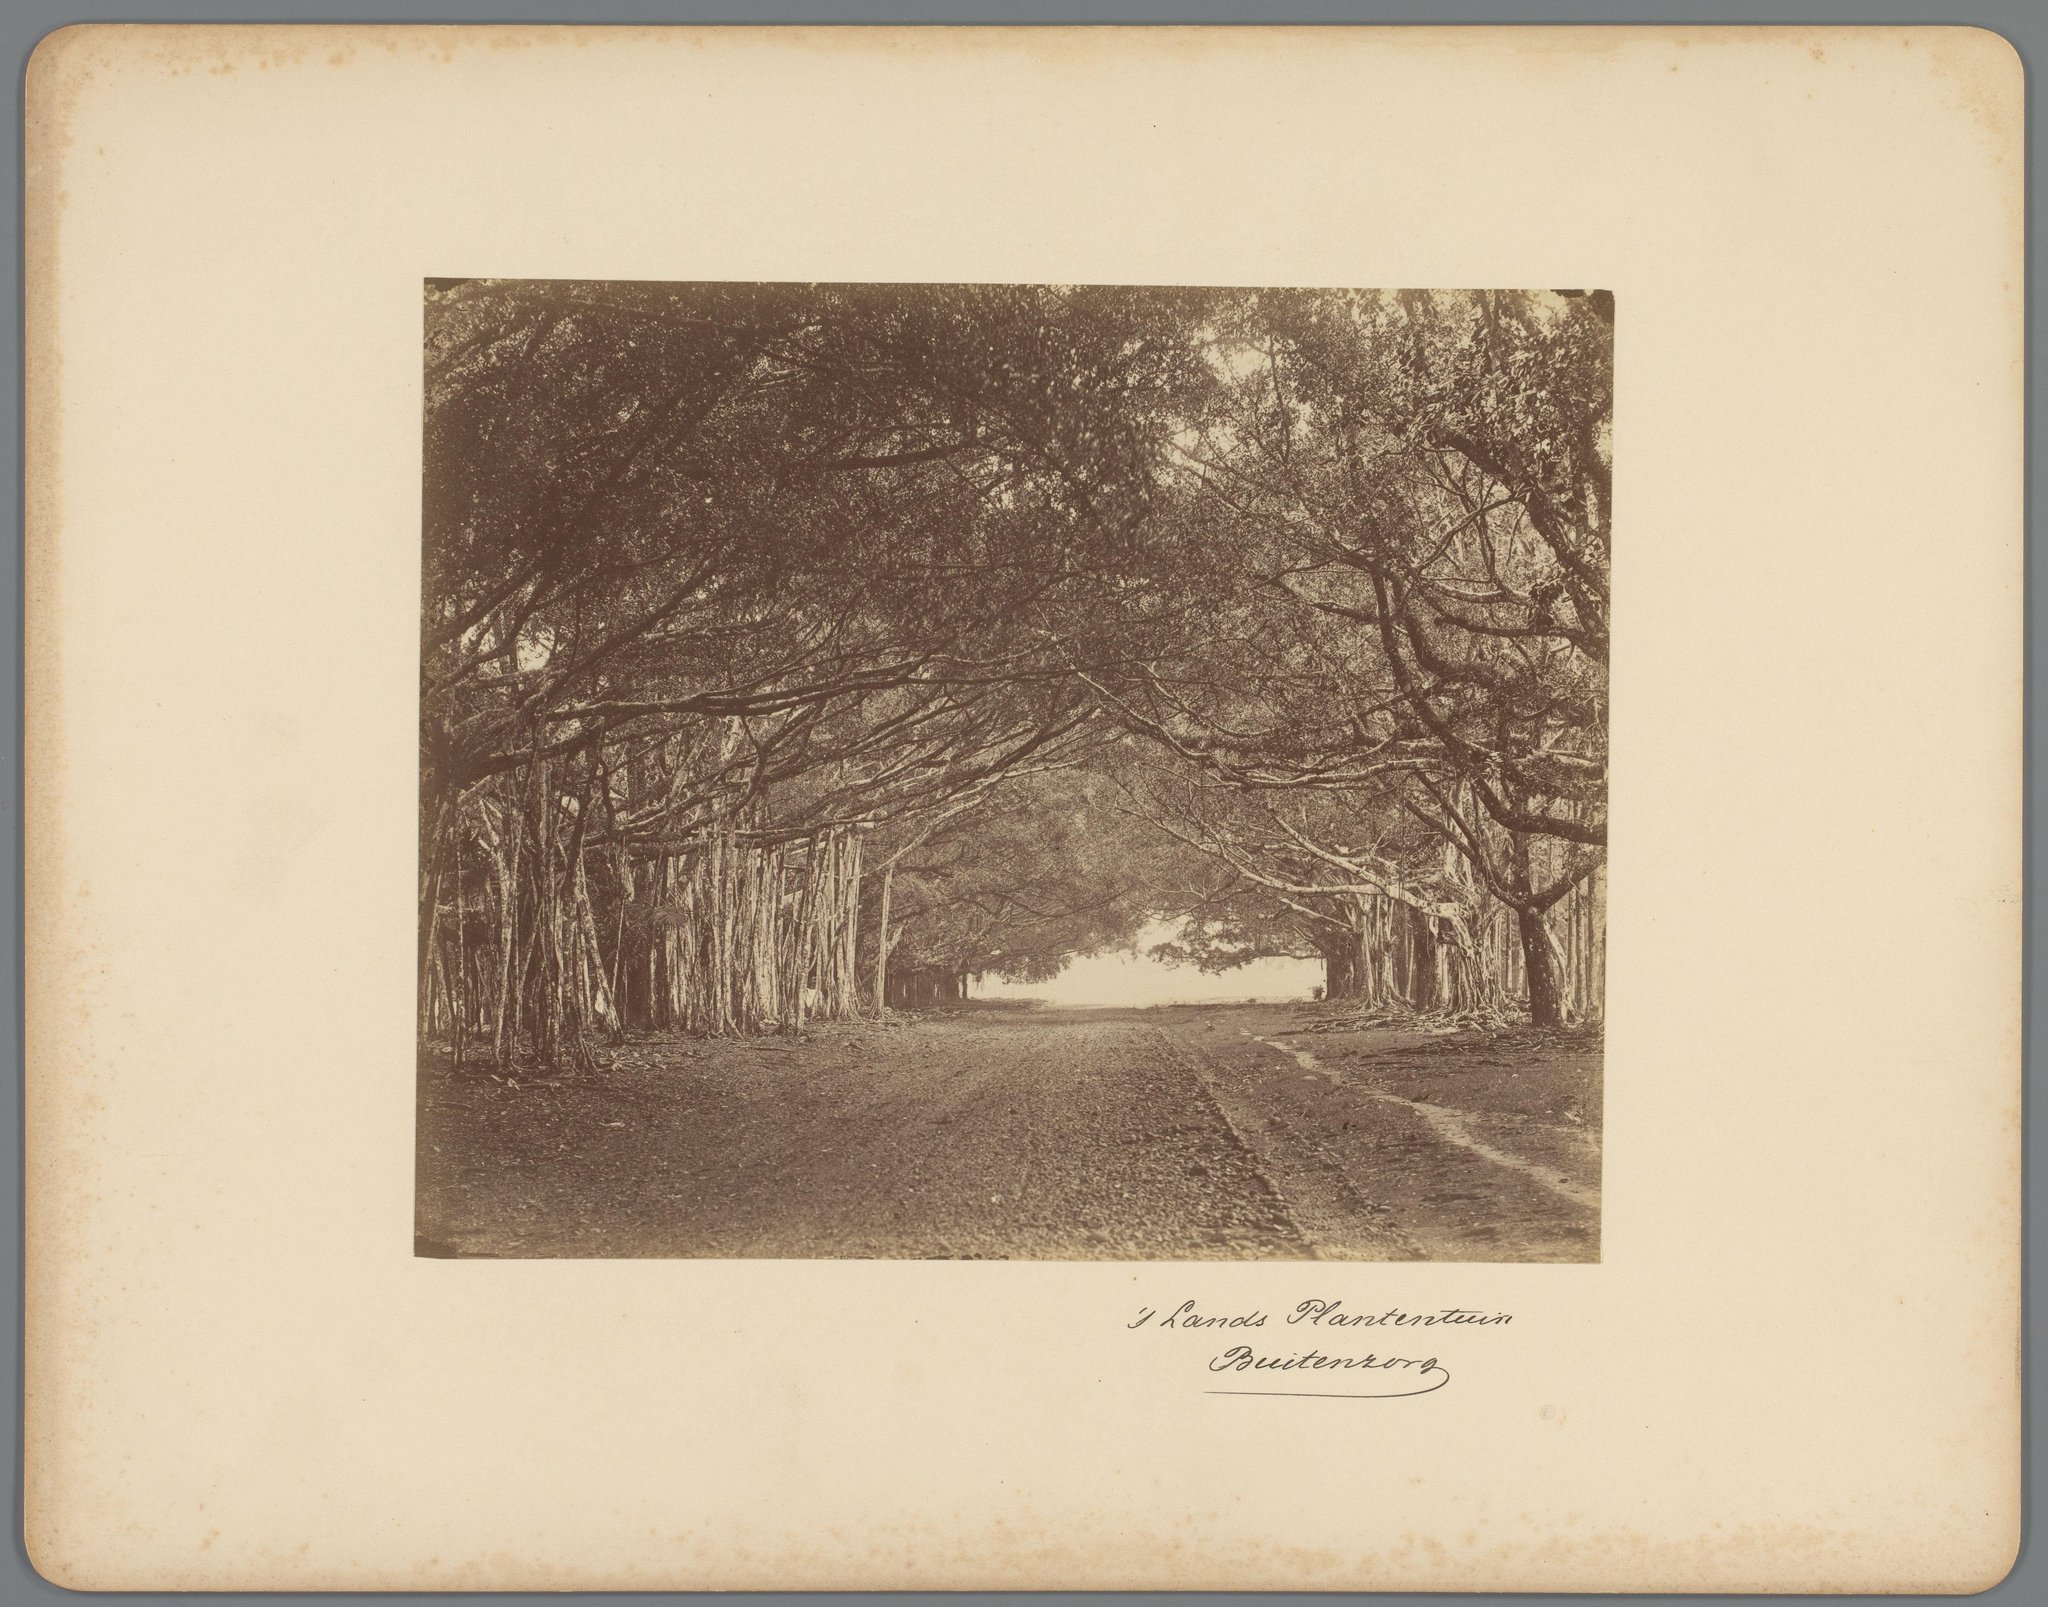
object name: photograph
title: Brede laan in een bos te Bogor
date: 1857-1900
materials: cardboard, paper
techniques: albumen print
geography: bogor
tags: forest path or lane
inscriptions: inscription: ‘FOTO’, inscription: ‘PHOTOGRAFIEEN VAN NED: INDIE BATAVIA’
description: Deze foto zat oorspronkelijk in prentenkabinet RP-F-AA3192.